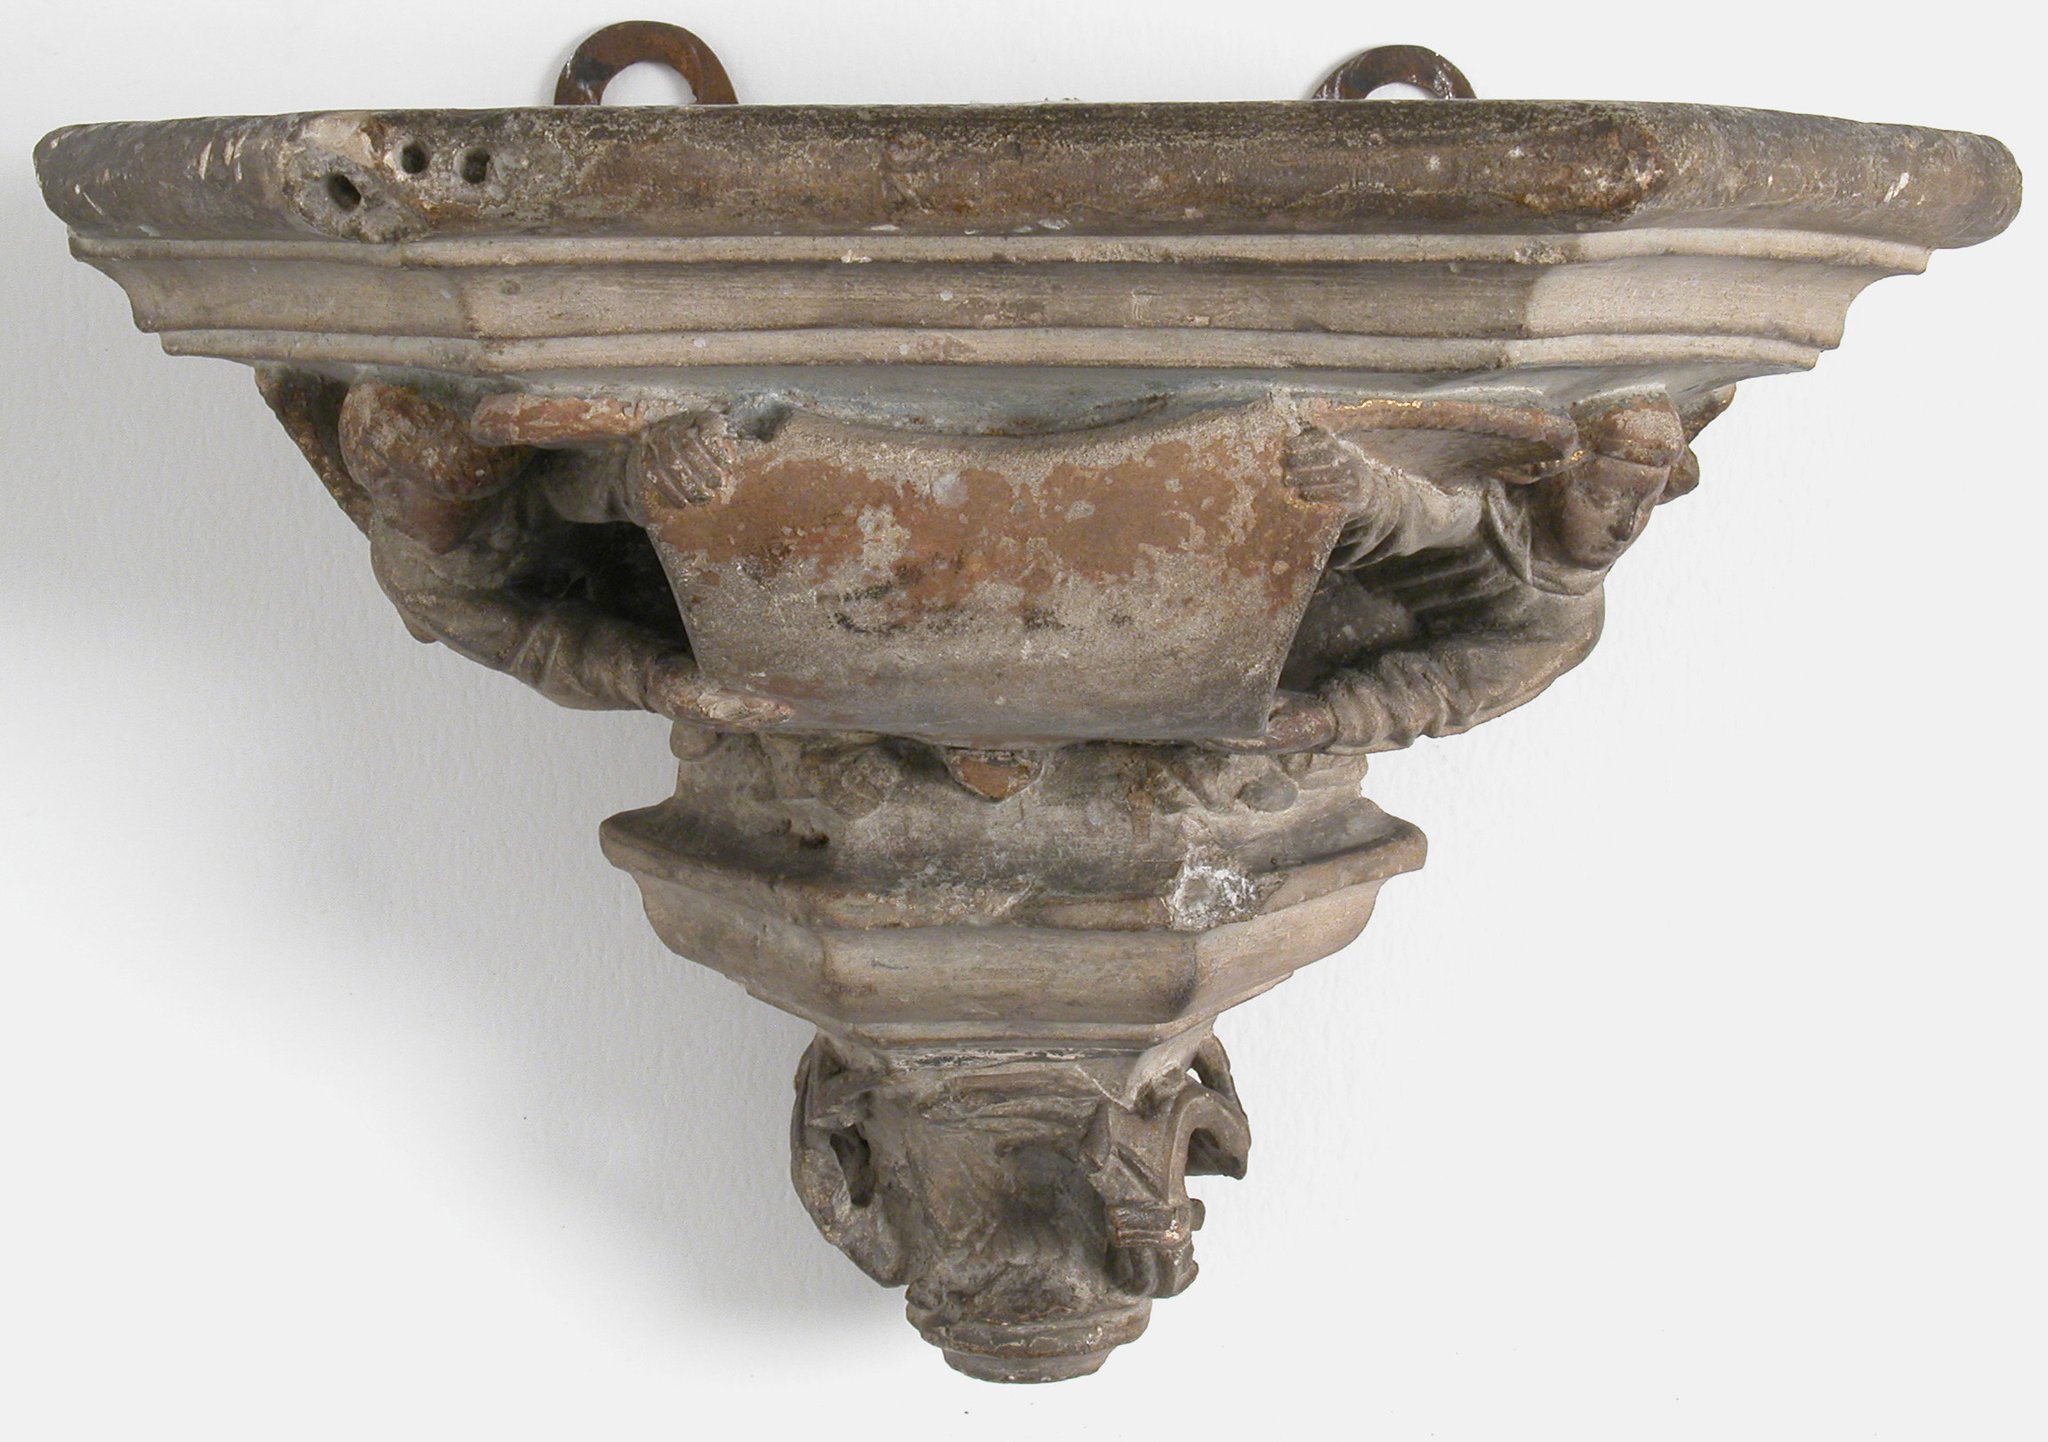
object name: corbel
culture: french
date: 1467-1500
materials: limestone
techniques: gilding, polychromy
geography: france